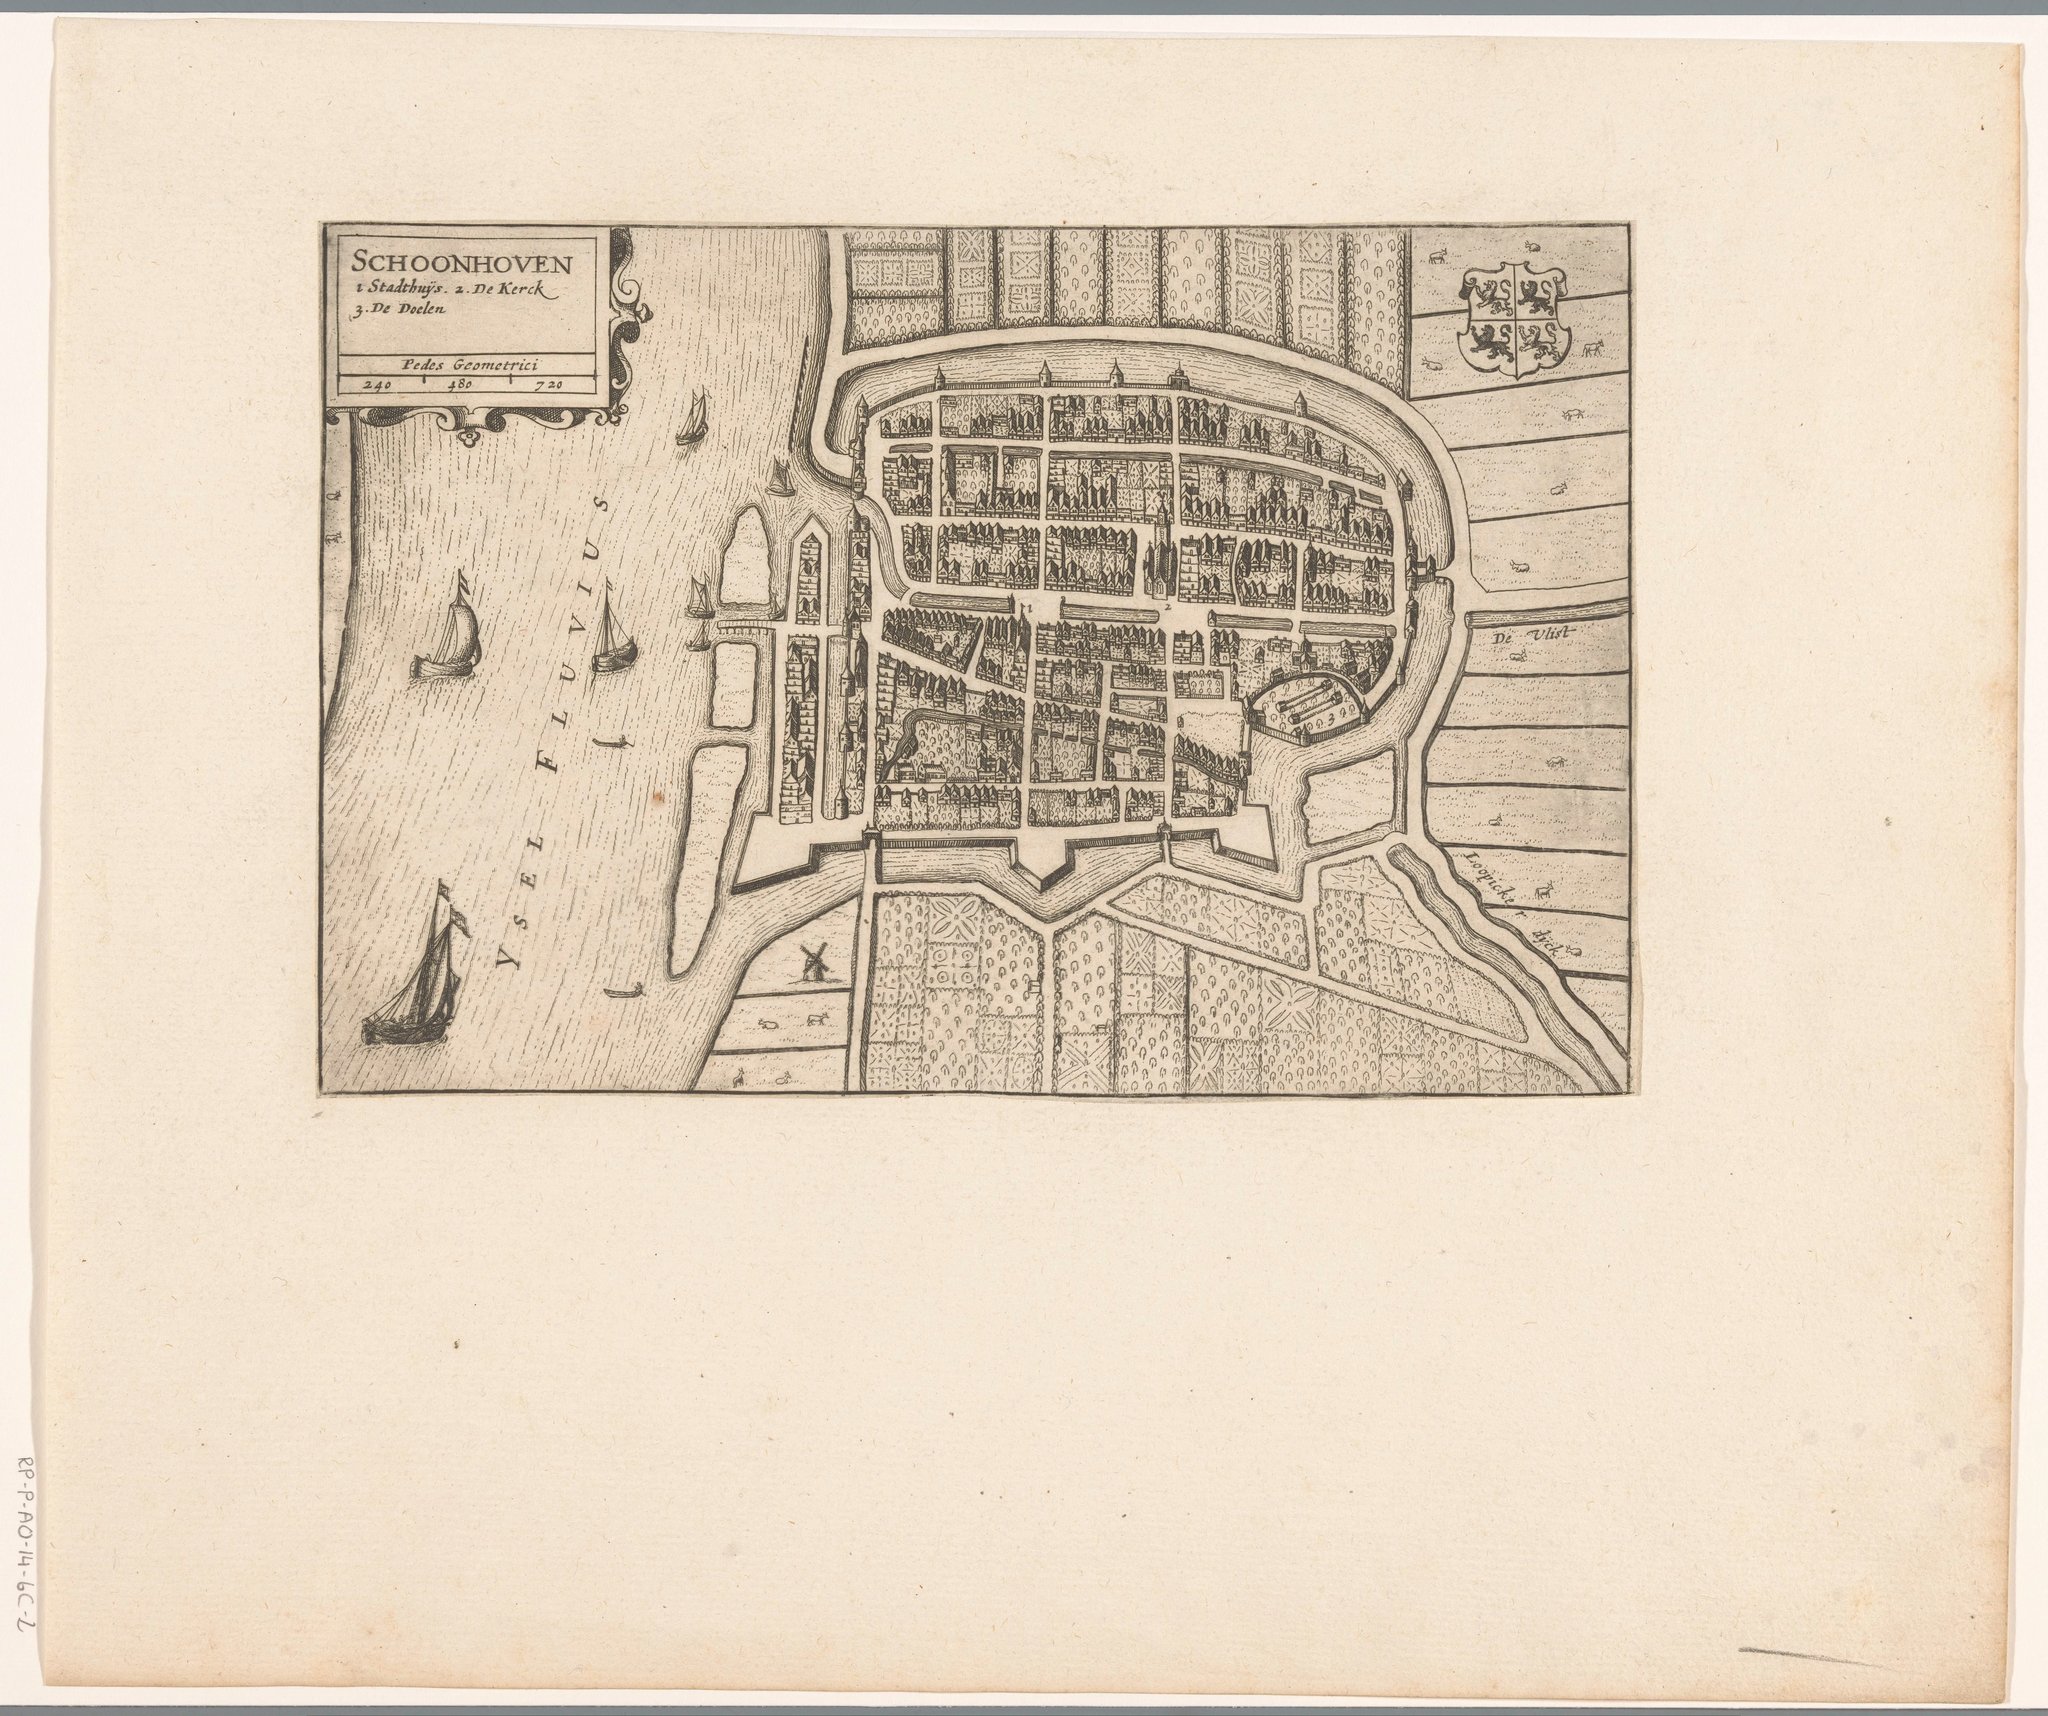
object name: area plan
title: Plattegrond van Schoonhoven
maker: Anonymous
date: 1632-1649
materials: paper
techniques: etching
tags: coat of arms (as symbol of the state, etc.) (+ city; municipal), maps of cities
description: Prent ook gebruikt in: Boxhorn, Marcus Zuerius van. Theatrum sive Hollandiae comitatus et urbium nova descriptio (…). Amsterdam: Henricus Hondius, 1632. En in sommige exemplaren van: Blaeu, Johannes Willemszoon. Novum ac magnum theatrum urbium Belgicae (...). 2 delen. 2e druk. Amsterdam: Johannes Willemszoon Blaeu, 1649, dl. 1.